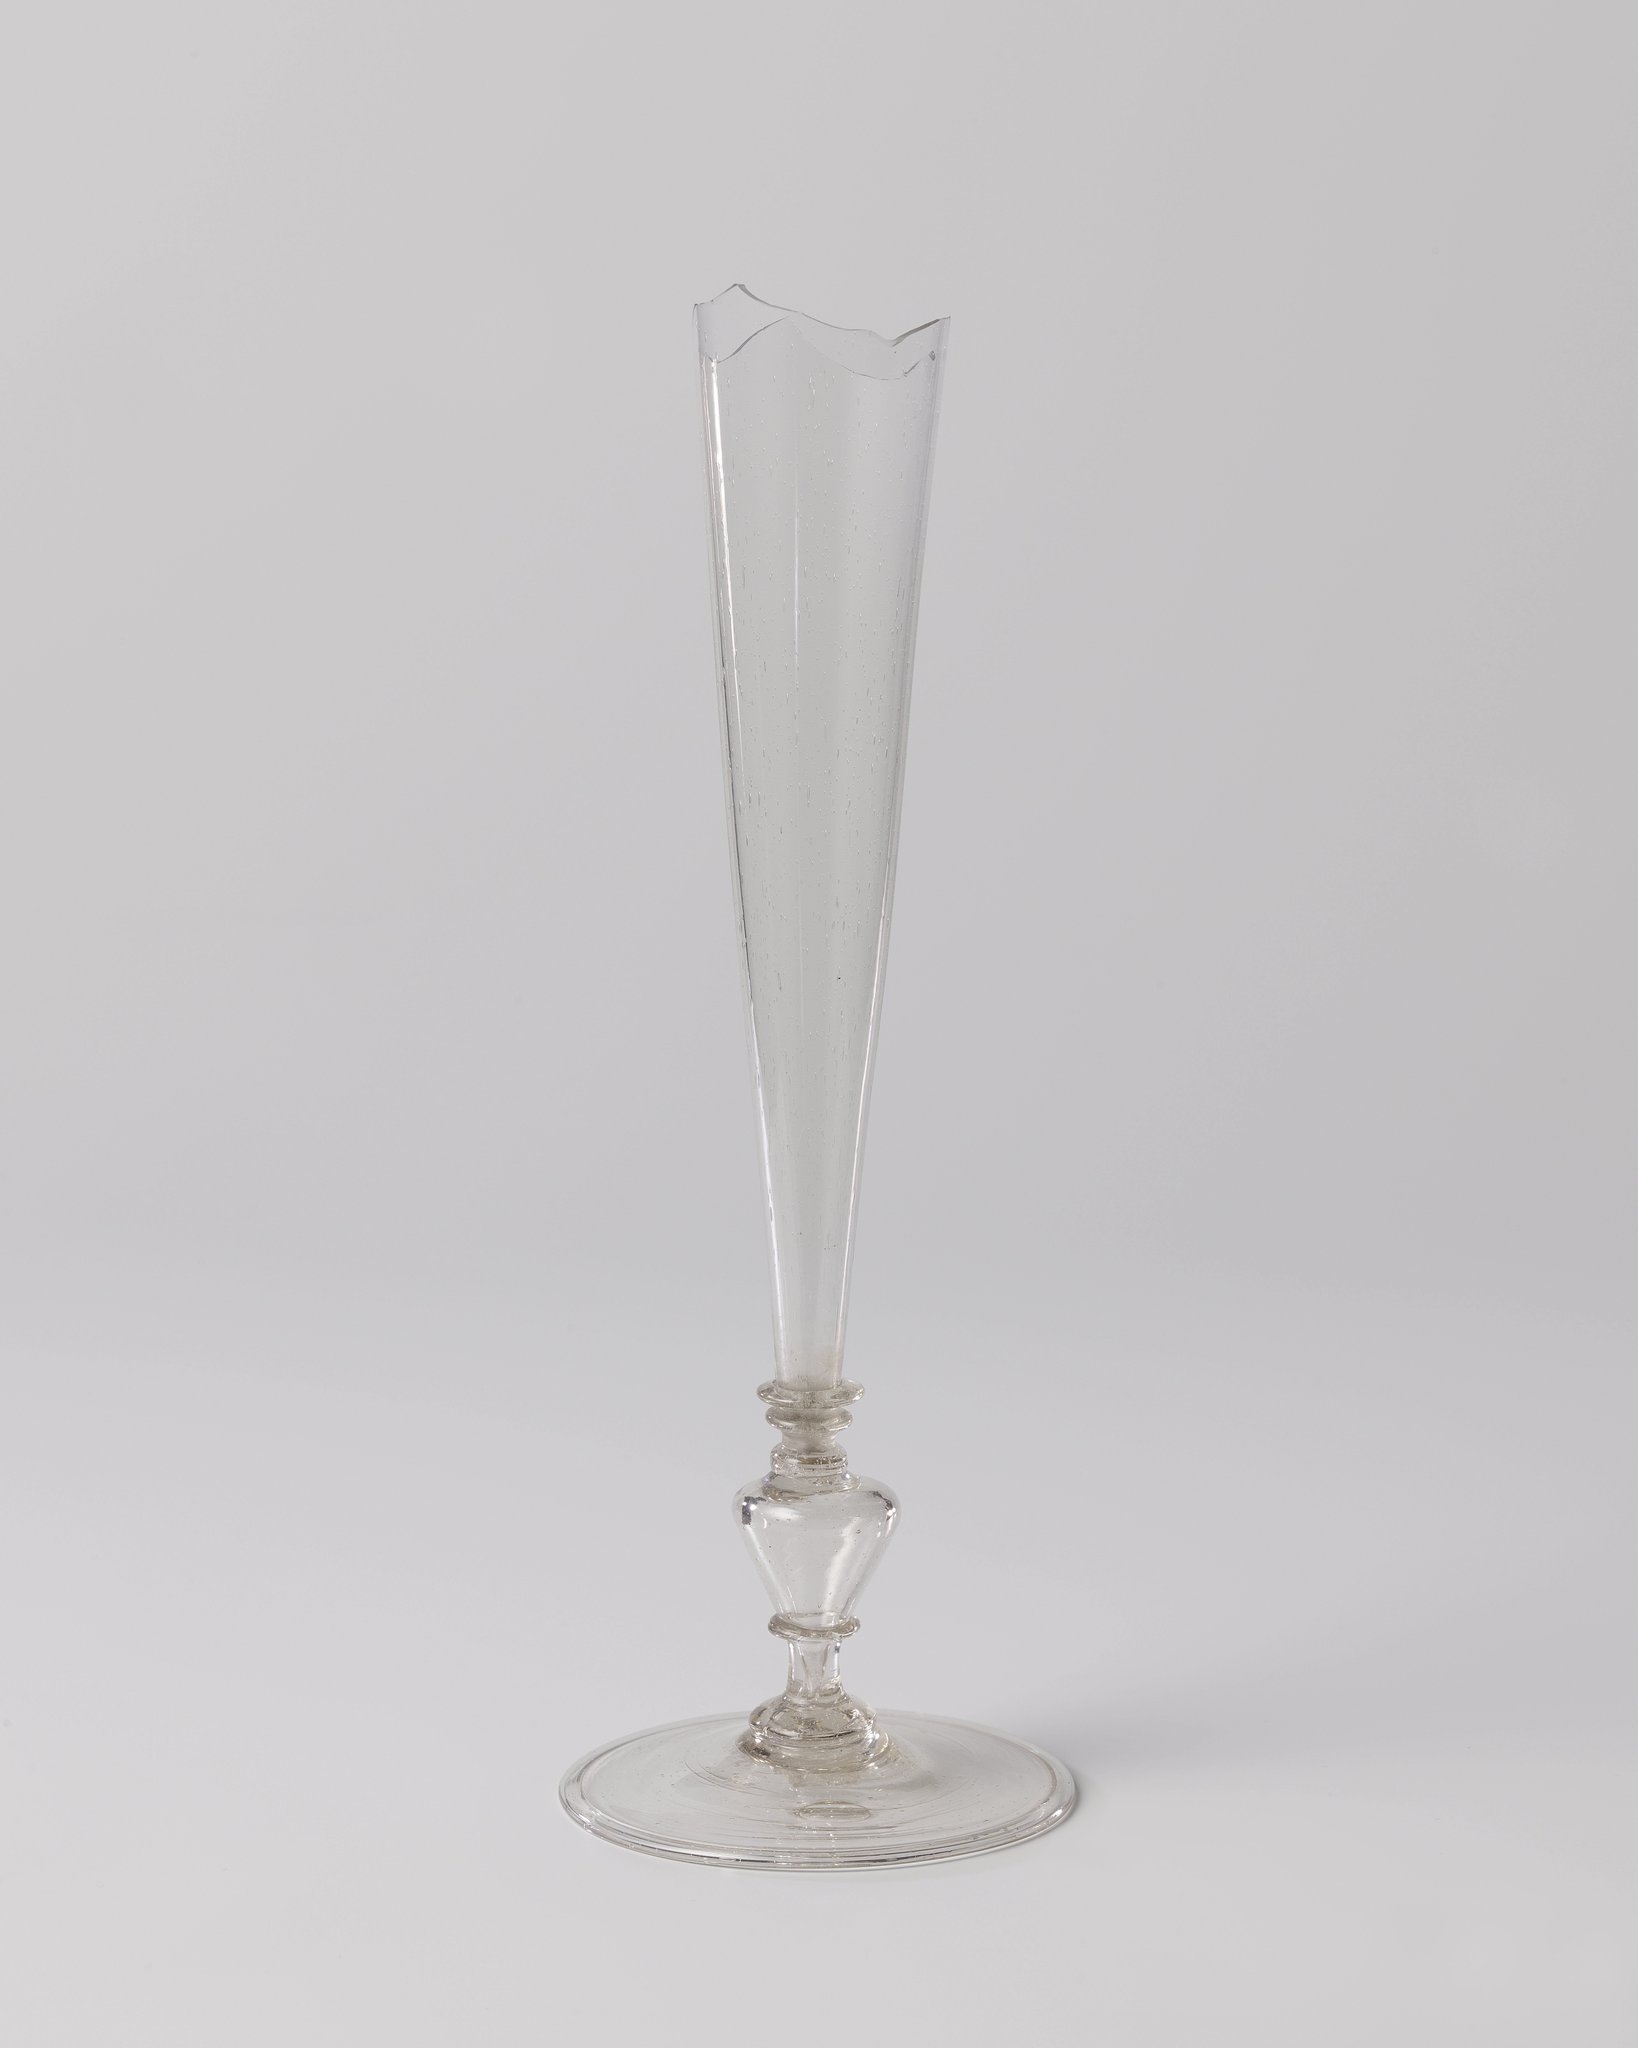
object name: flute glass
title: Fluitglas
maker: Anonymous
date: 1600-1700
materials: glass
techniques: façon de venise, glassblowing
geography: low countries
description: Platte voet met omgeslagen rand. De stam opgebouwd uit een holle baluster en een schijf. Trechtervormige kelk. Eenderde van de kelk ontbreekt.